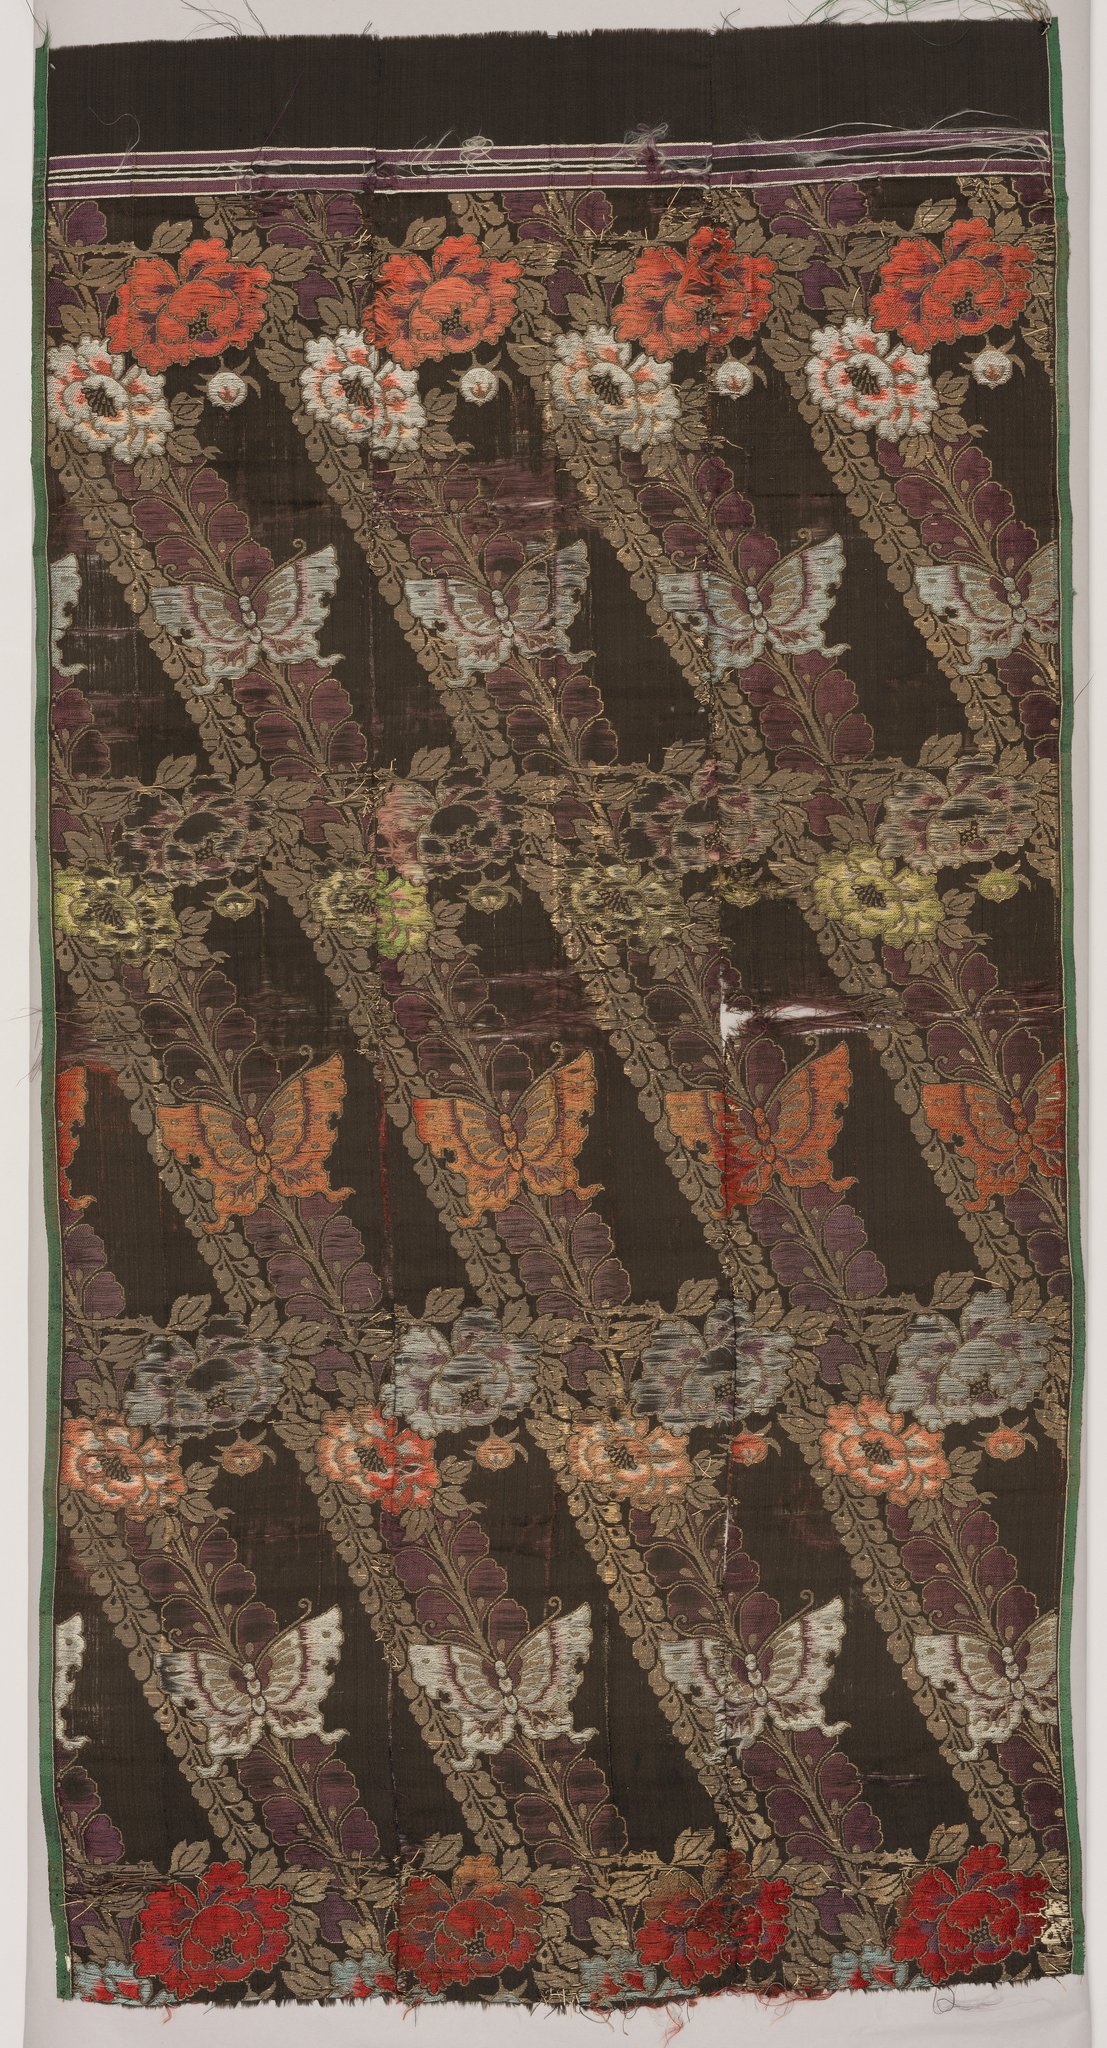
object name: piece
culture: japanese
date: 1801-1900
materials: silk